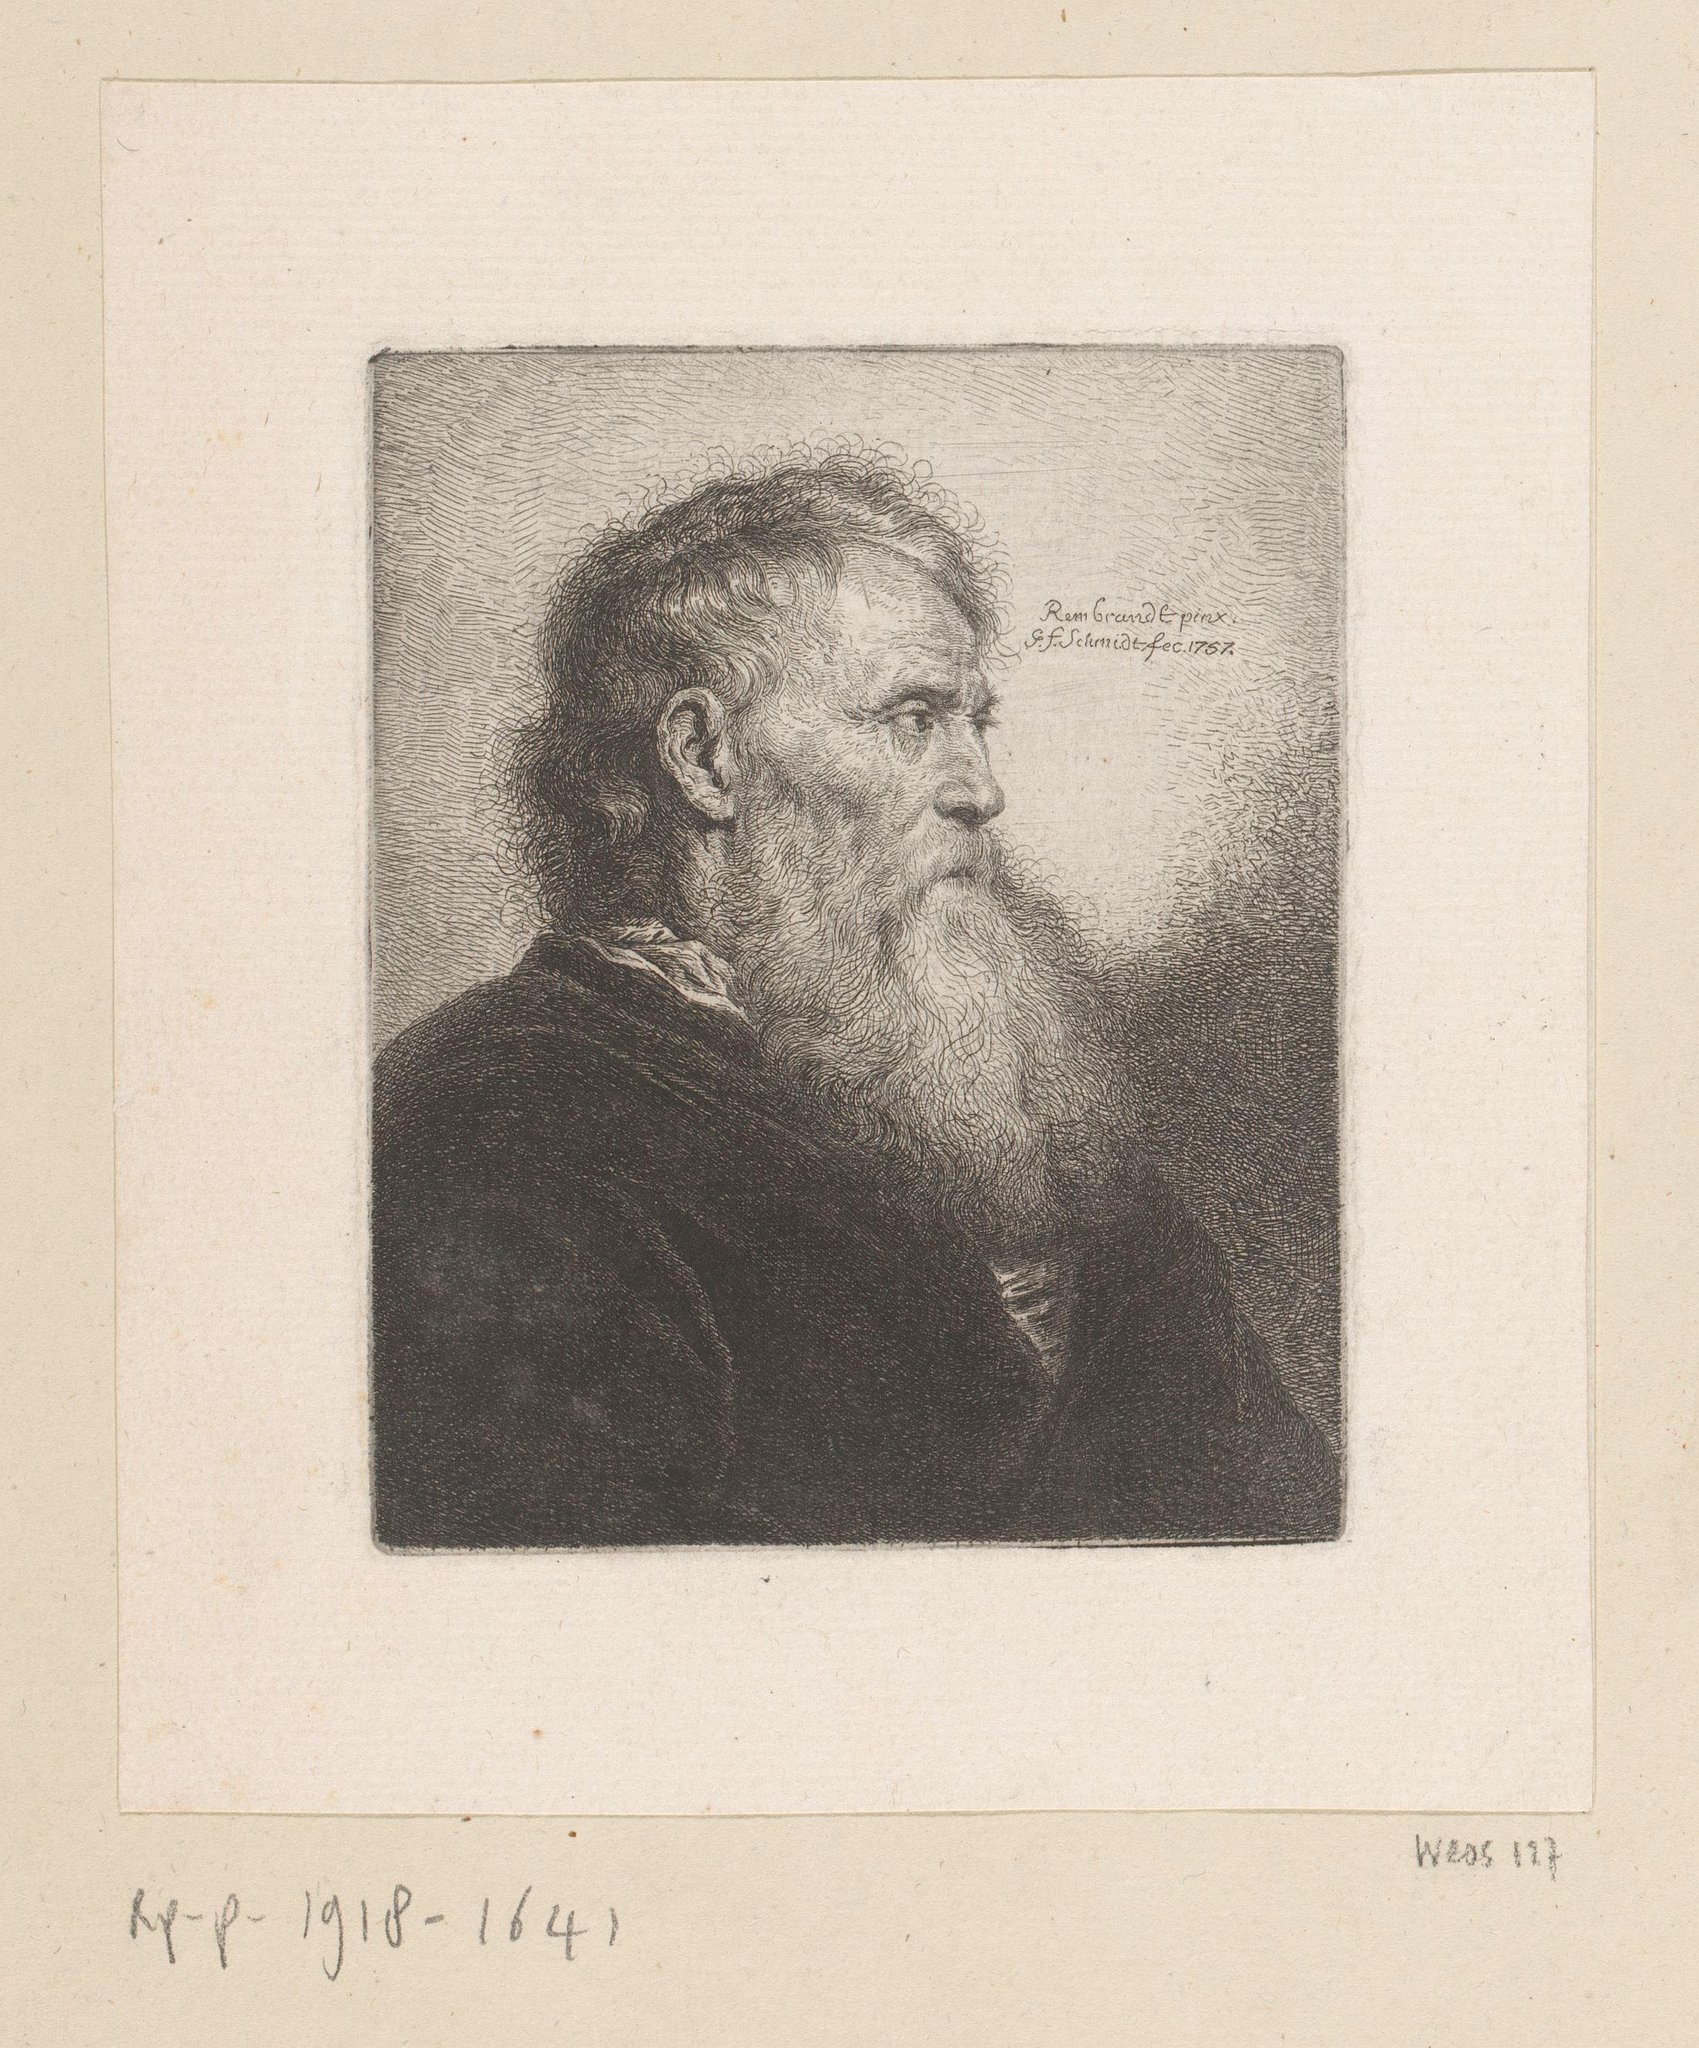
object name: print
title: Oude man met baard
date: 1757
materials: paper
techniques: etching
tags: old man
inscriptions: date